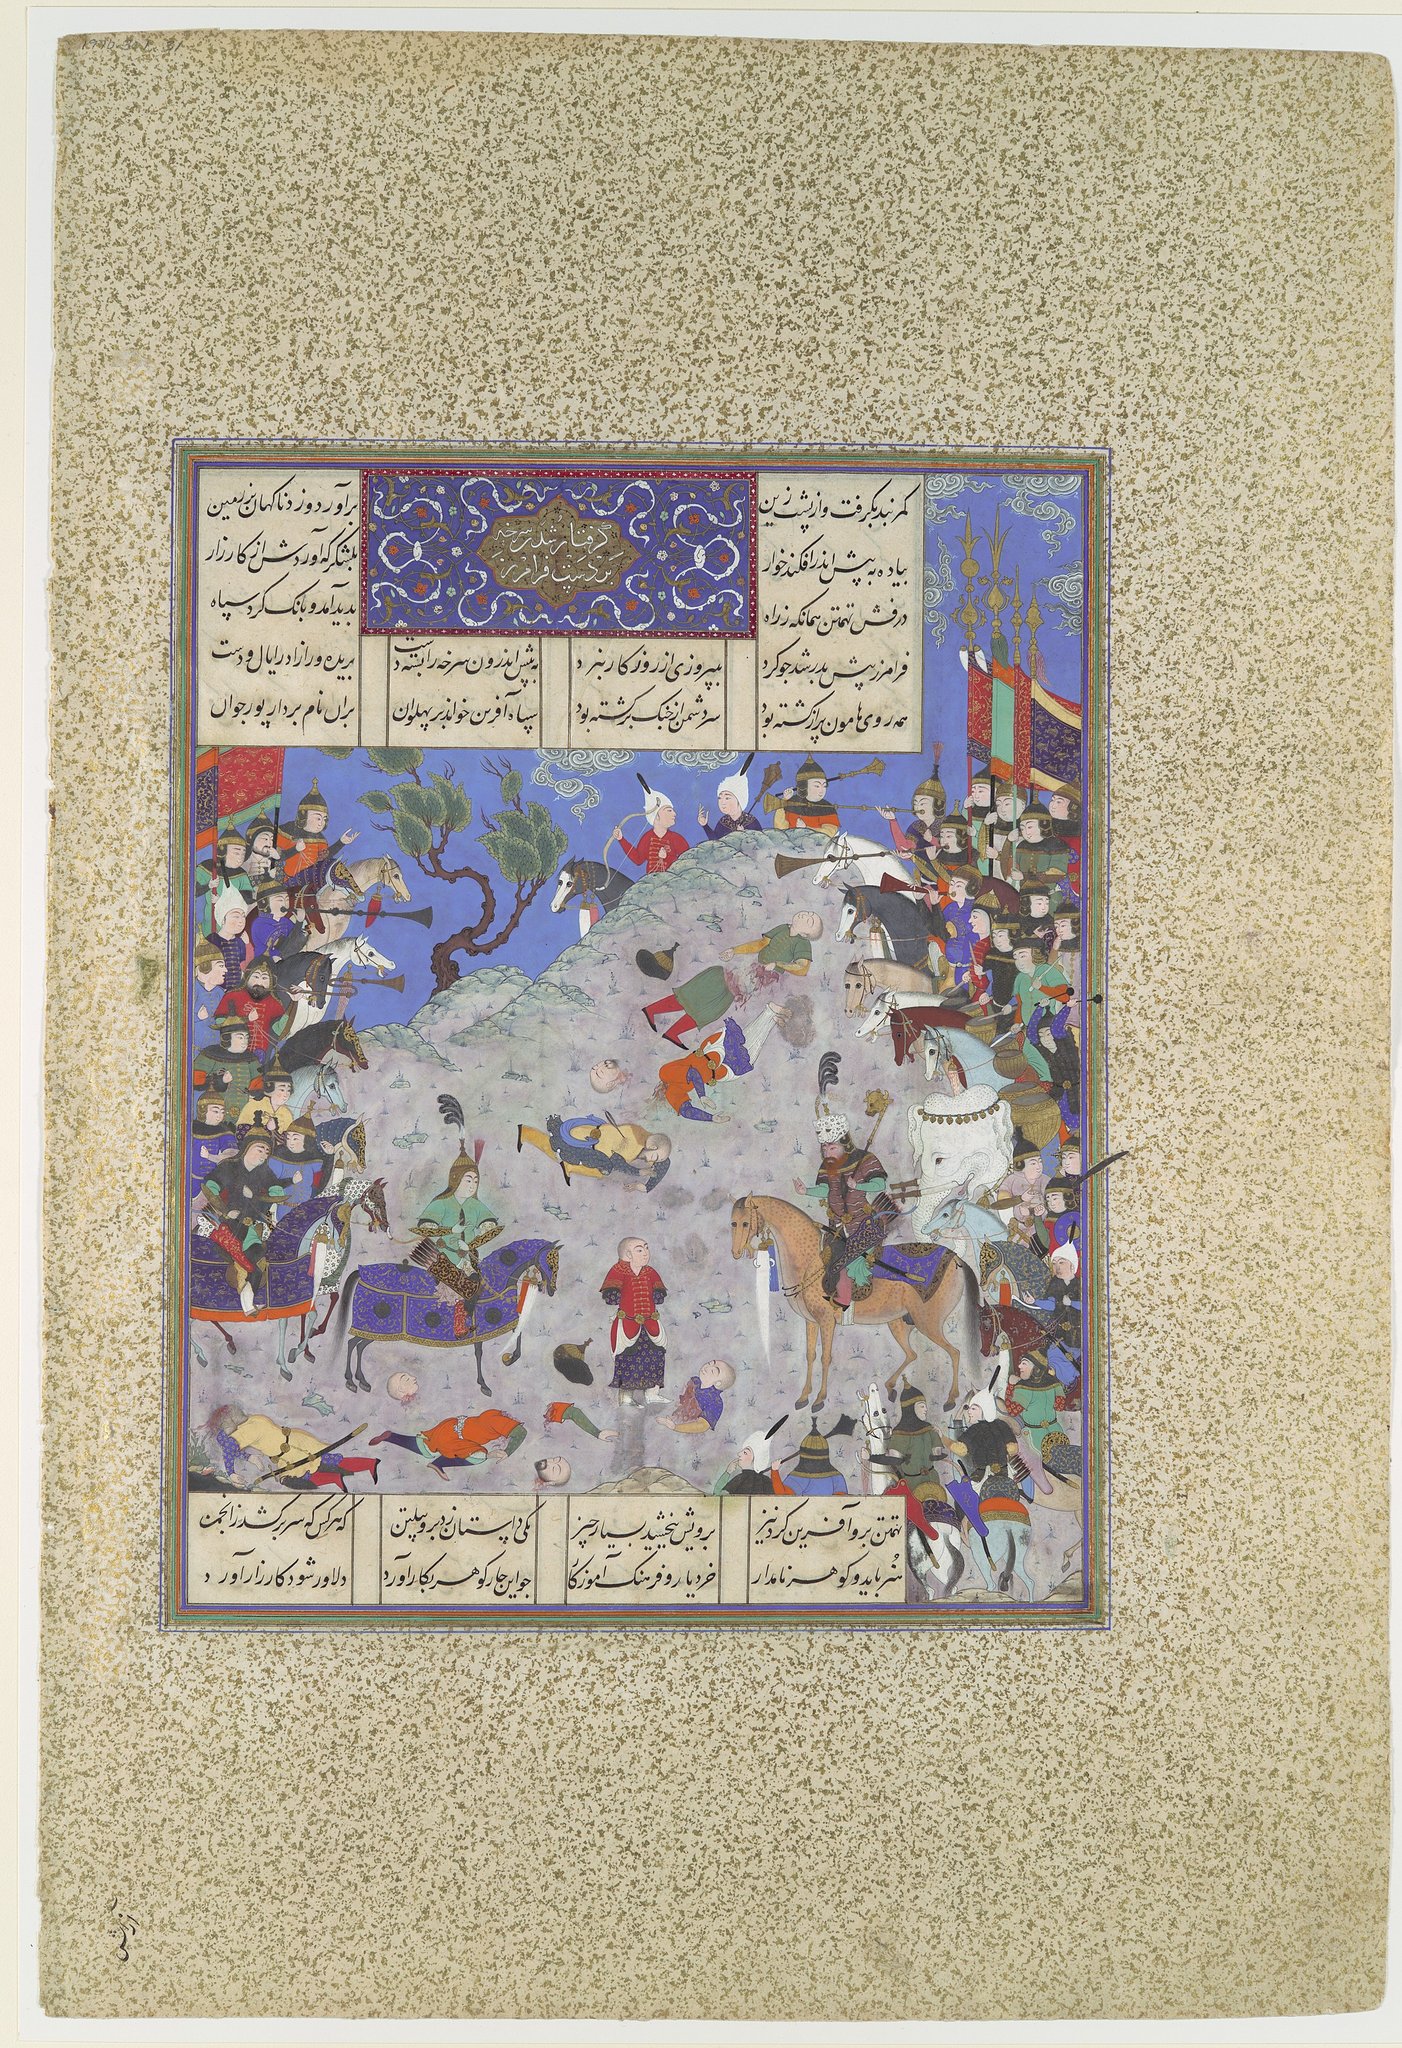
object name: folio from an illustrated manuscript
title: "Surkha Captured by Faramarz is Condemned by Rustam", Folio 204v from the Shahnama (Book of Kings) of Shah Tahmasp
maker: abu'l qasim firdausi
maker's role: author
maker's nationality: iranian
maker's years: 935-1020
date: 1525-1530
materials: gold, ink, paper, silver, watercolor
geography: iran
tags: battles,men,elephants,horses,death